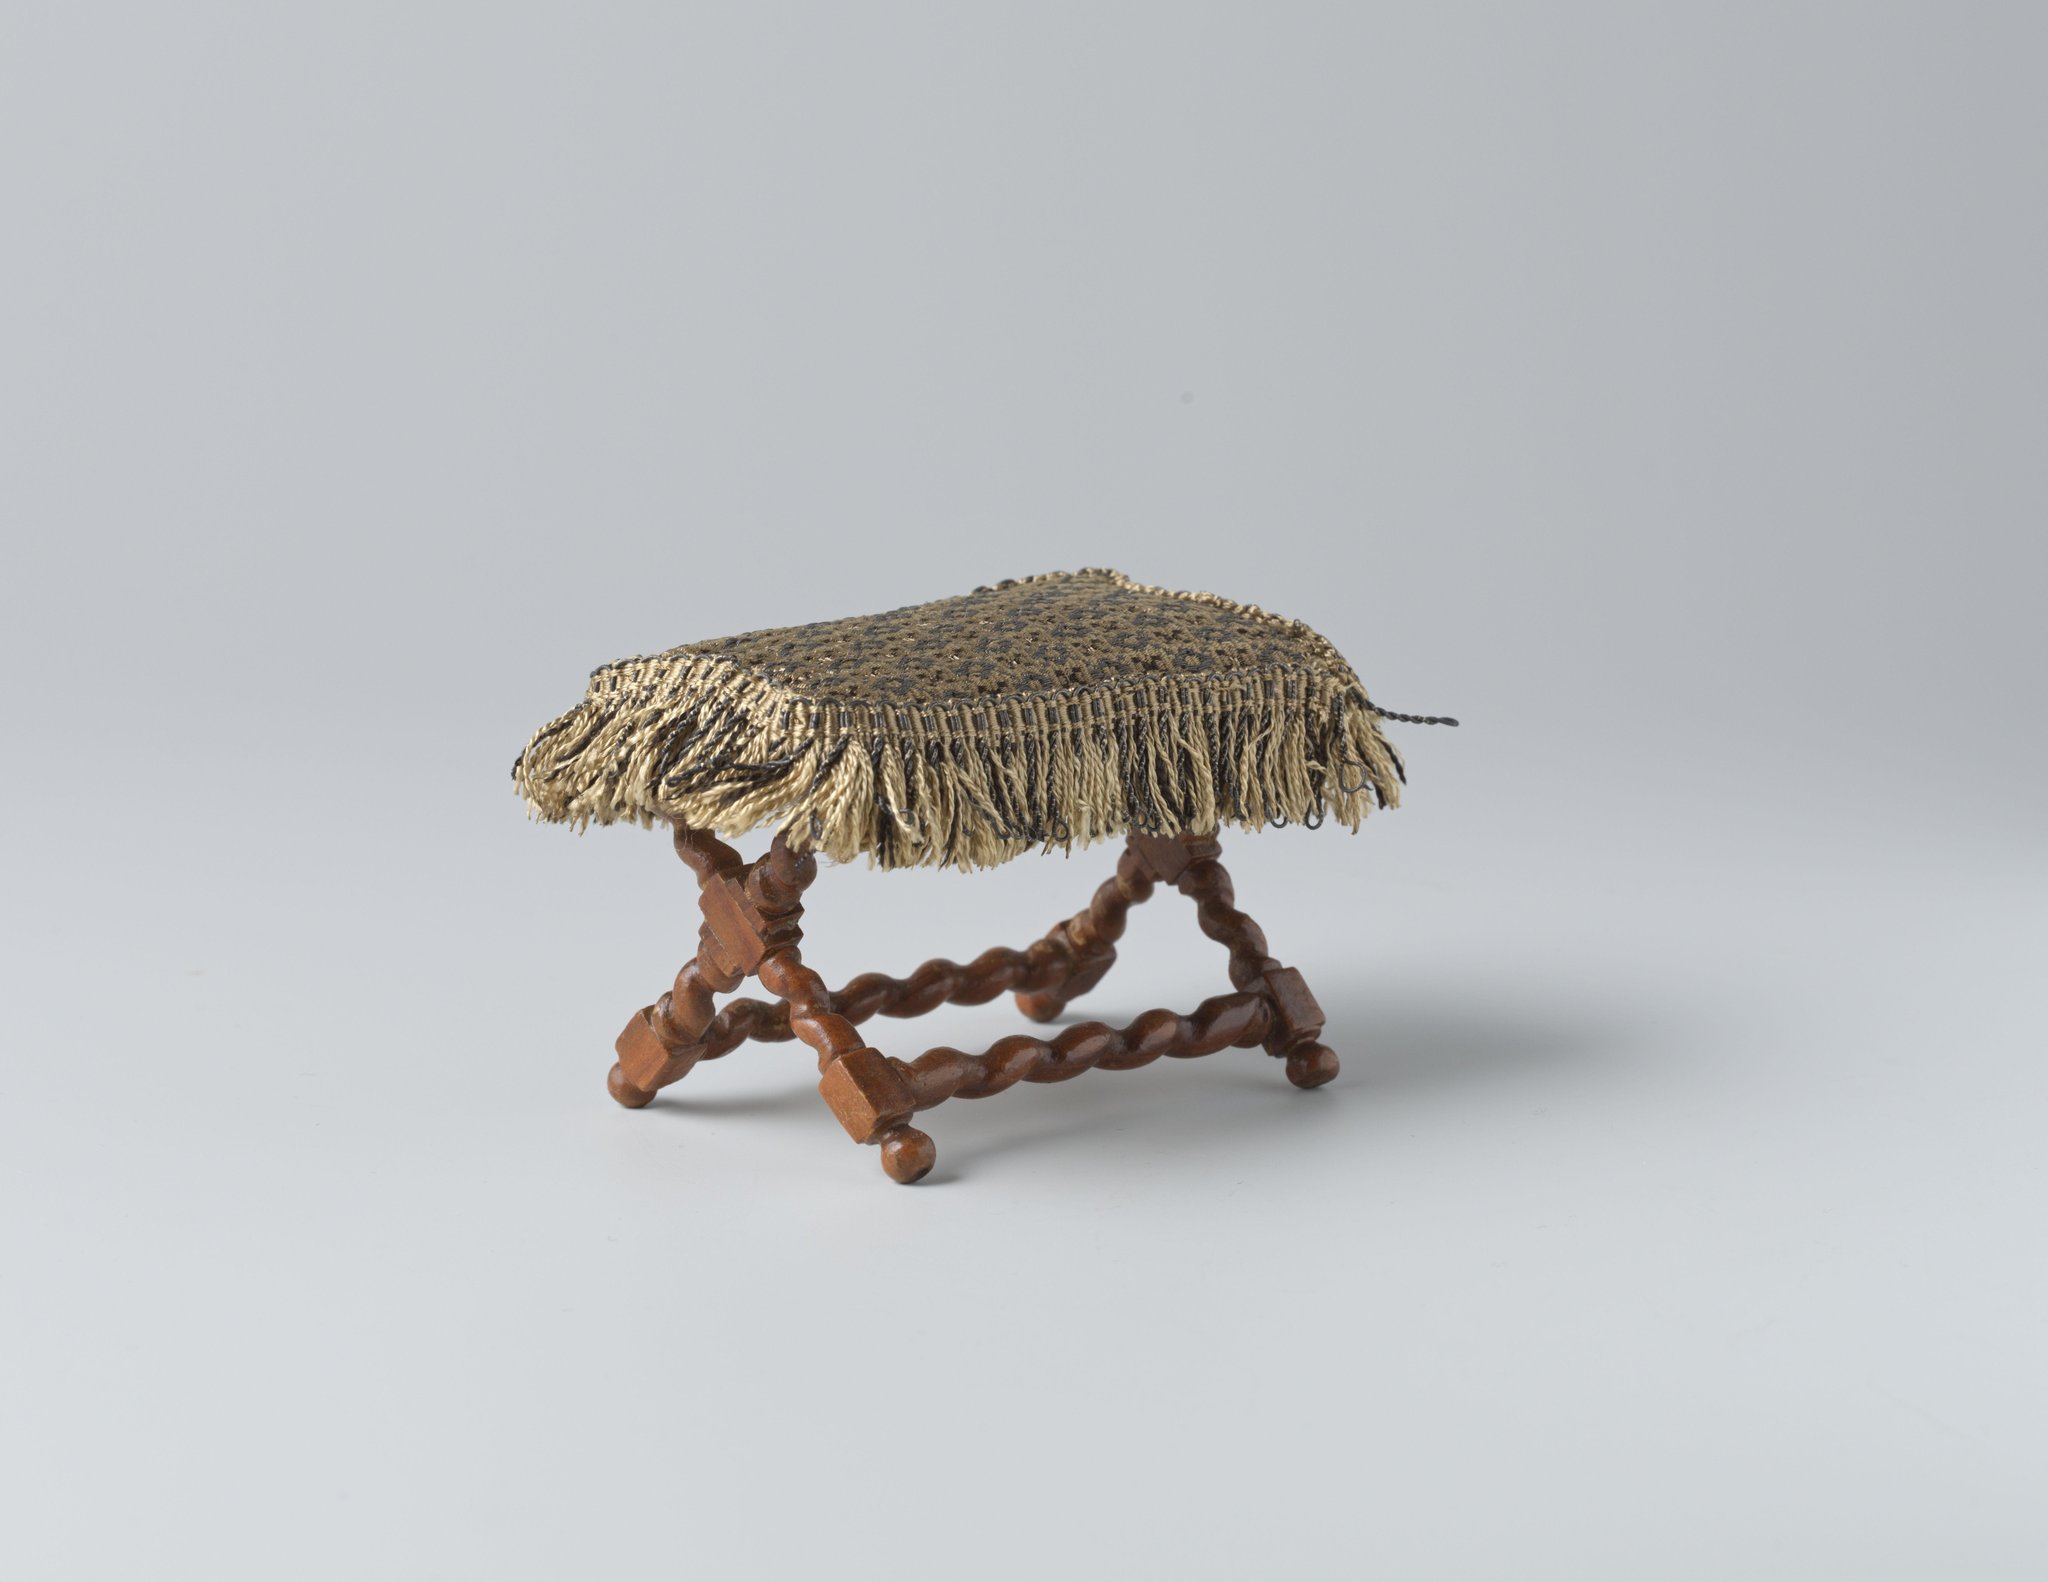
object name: miniature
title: Taboeret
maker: Anonymous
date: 1676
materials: linen, wood, silk, thread, wool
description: Taboeret met rechthoekige zitting, op getorste poten van olijfhout, de poten zijn twee aan twee gekruist en worden verbonden aan de onderzijde door twee getorste dwarspoten, en boven door twee gladde dwarsregels. Tussen de bovenregels is de zitting gespannen, bestaande uit een linnen onderlaag, waarop wolpluis, afgedekt door een complex weefsel van zijde en metaaldraad met geometrisch patroon in de kleuren geel en zwart. De stof is rondom afgezet met passement met franje van dezelfde gele en zwarte zijde en verguld zilverdraad.